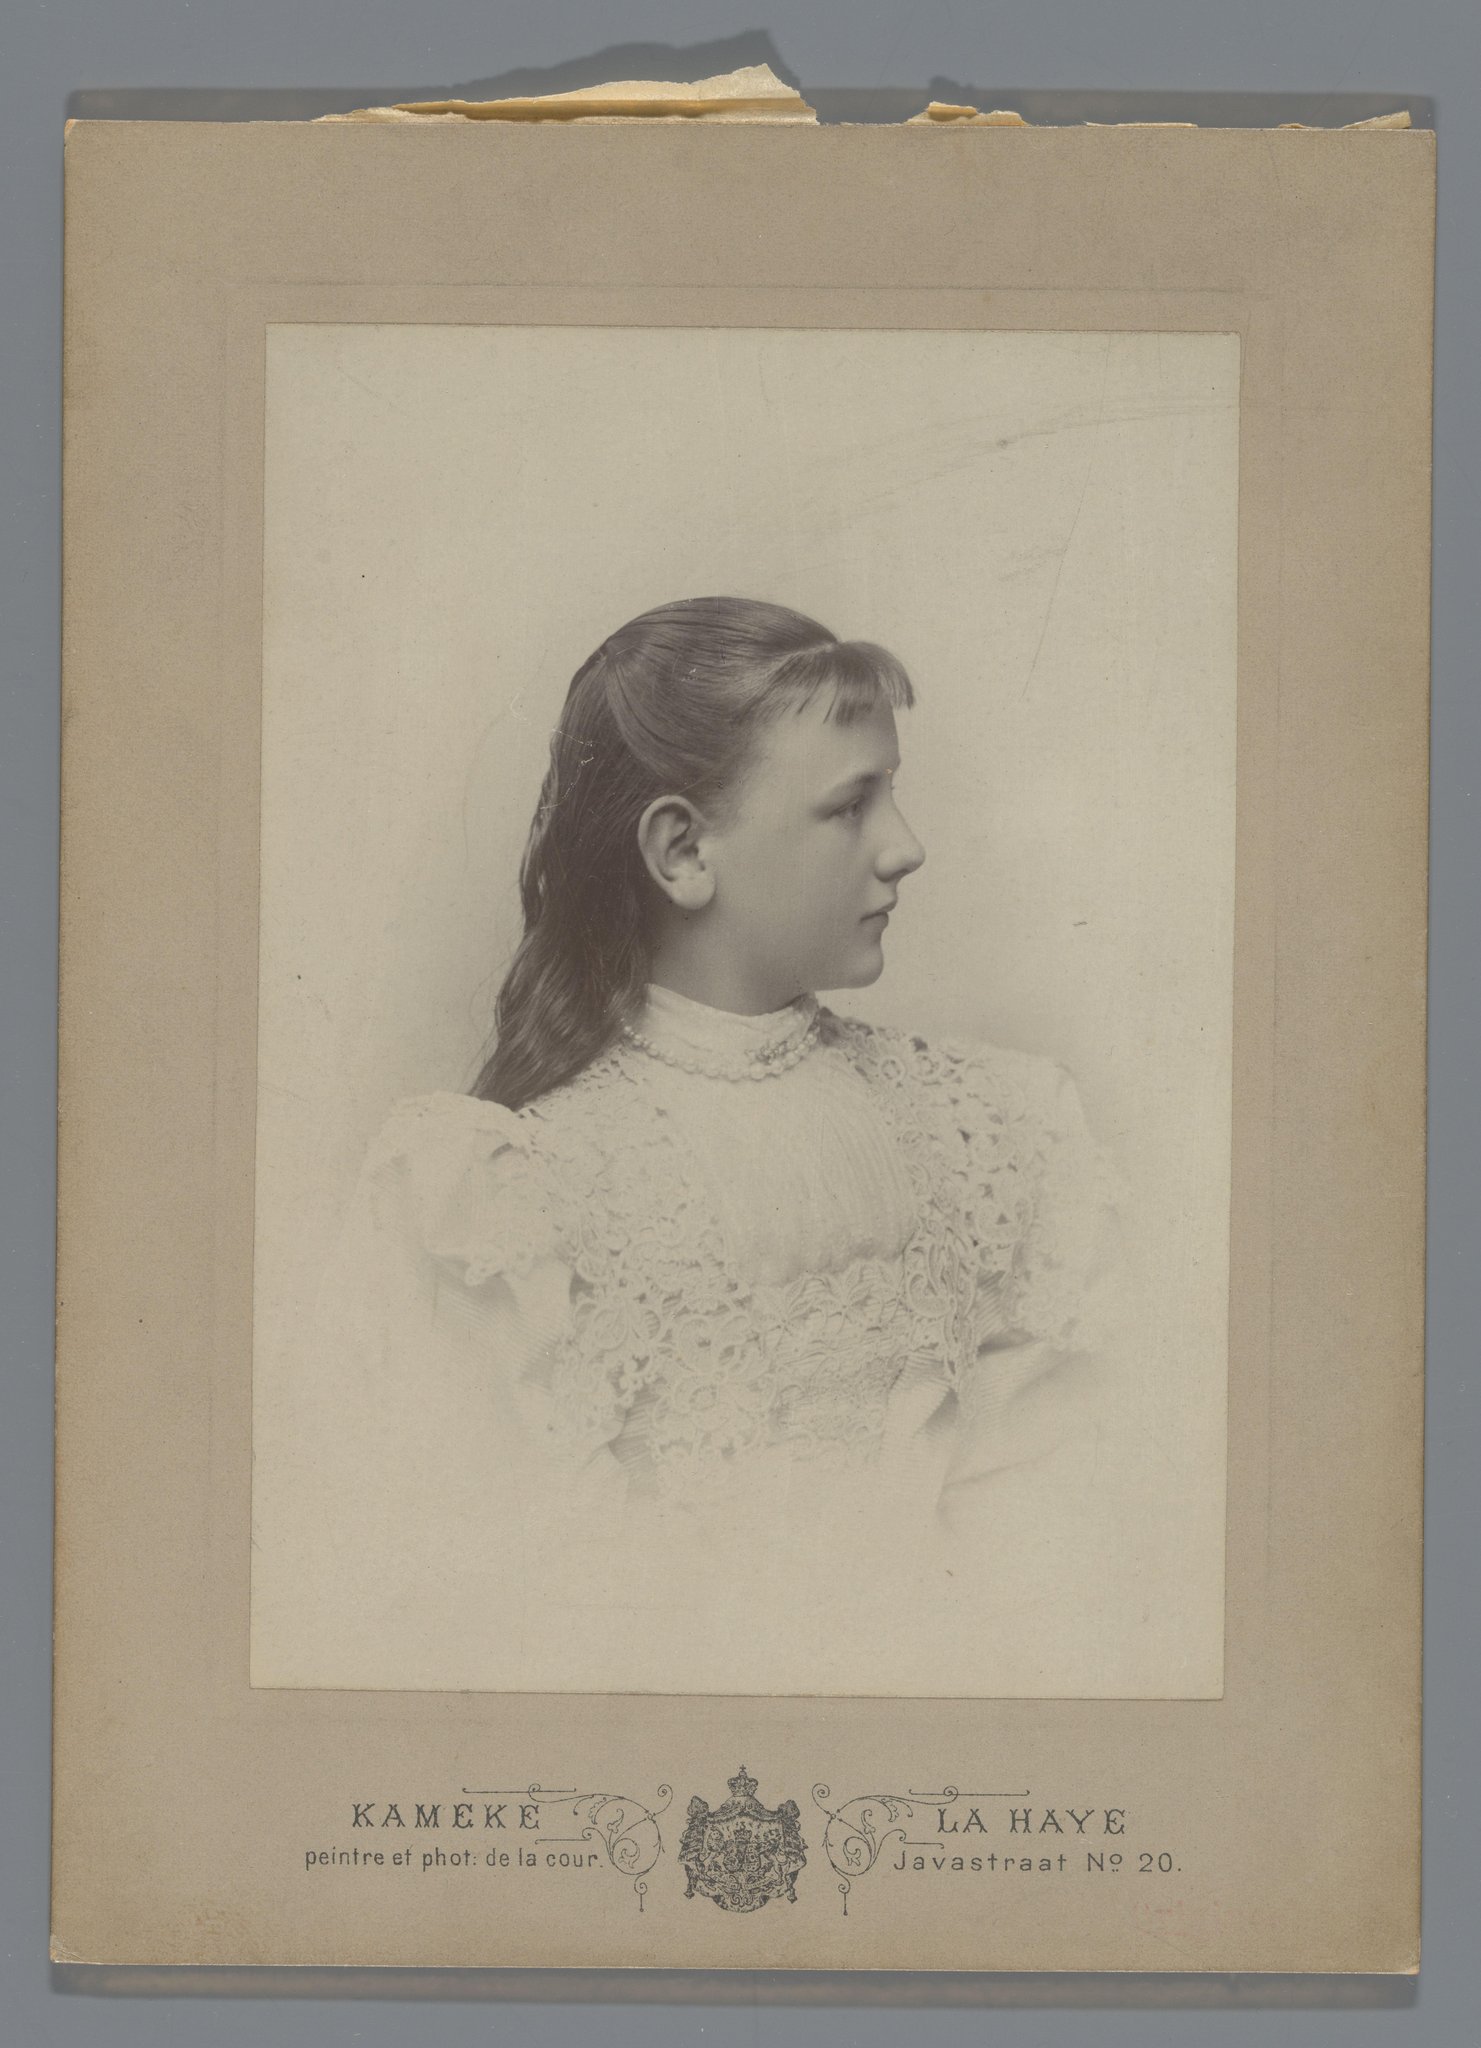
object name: photograph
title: Portret van prinses Wilhelmina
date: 1894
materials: paper, cardboard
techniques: gelatin silver print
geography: the hague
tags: the hague, print maker, wilhelmina of the netherlands, historical persons - bb - woman, girl (child between toddler and youth)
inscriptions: inscription: ‘Kameke/ peintre et phot: de la cour/ La Haye/ Javastraat No 20’, inscription: ‘Librairie Royale/ de/ M.M. Couvée/ Lange Pooten 41/ La Haye/ Photographies/ Tableaux Modernes/ Objets d'Art’